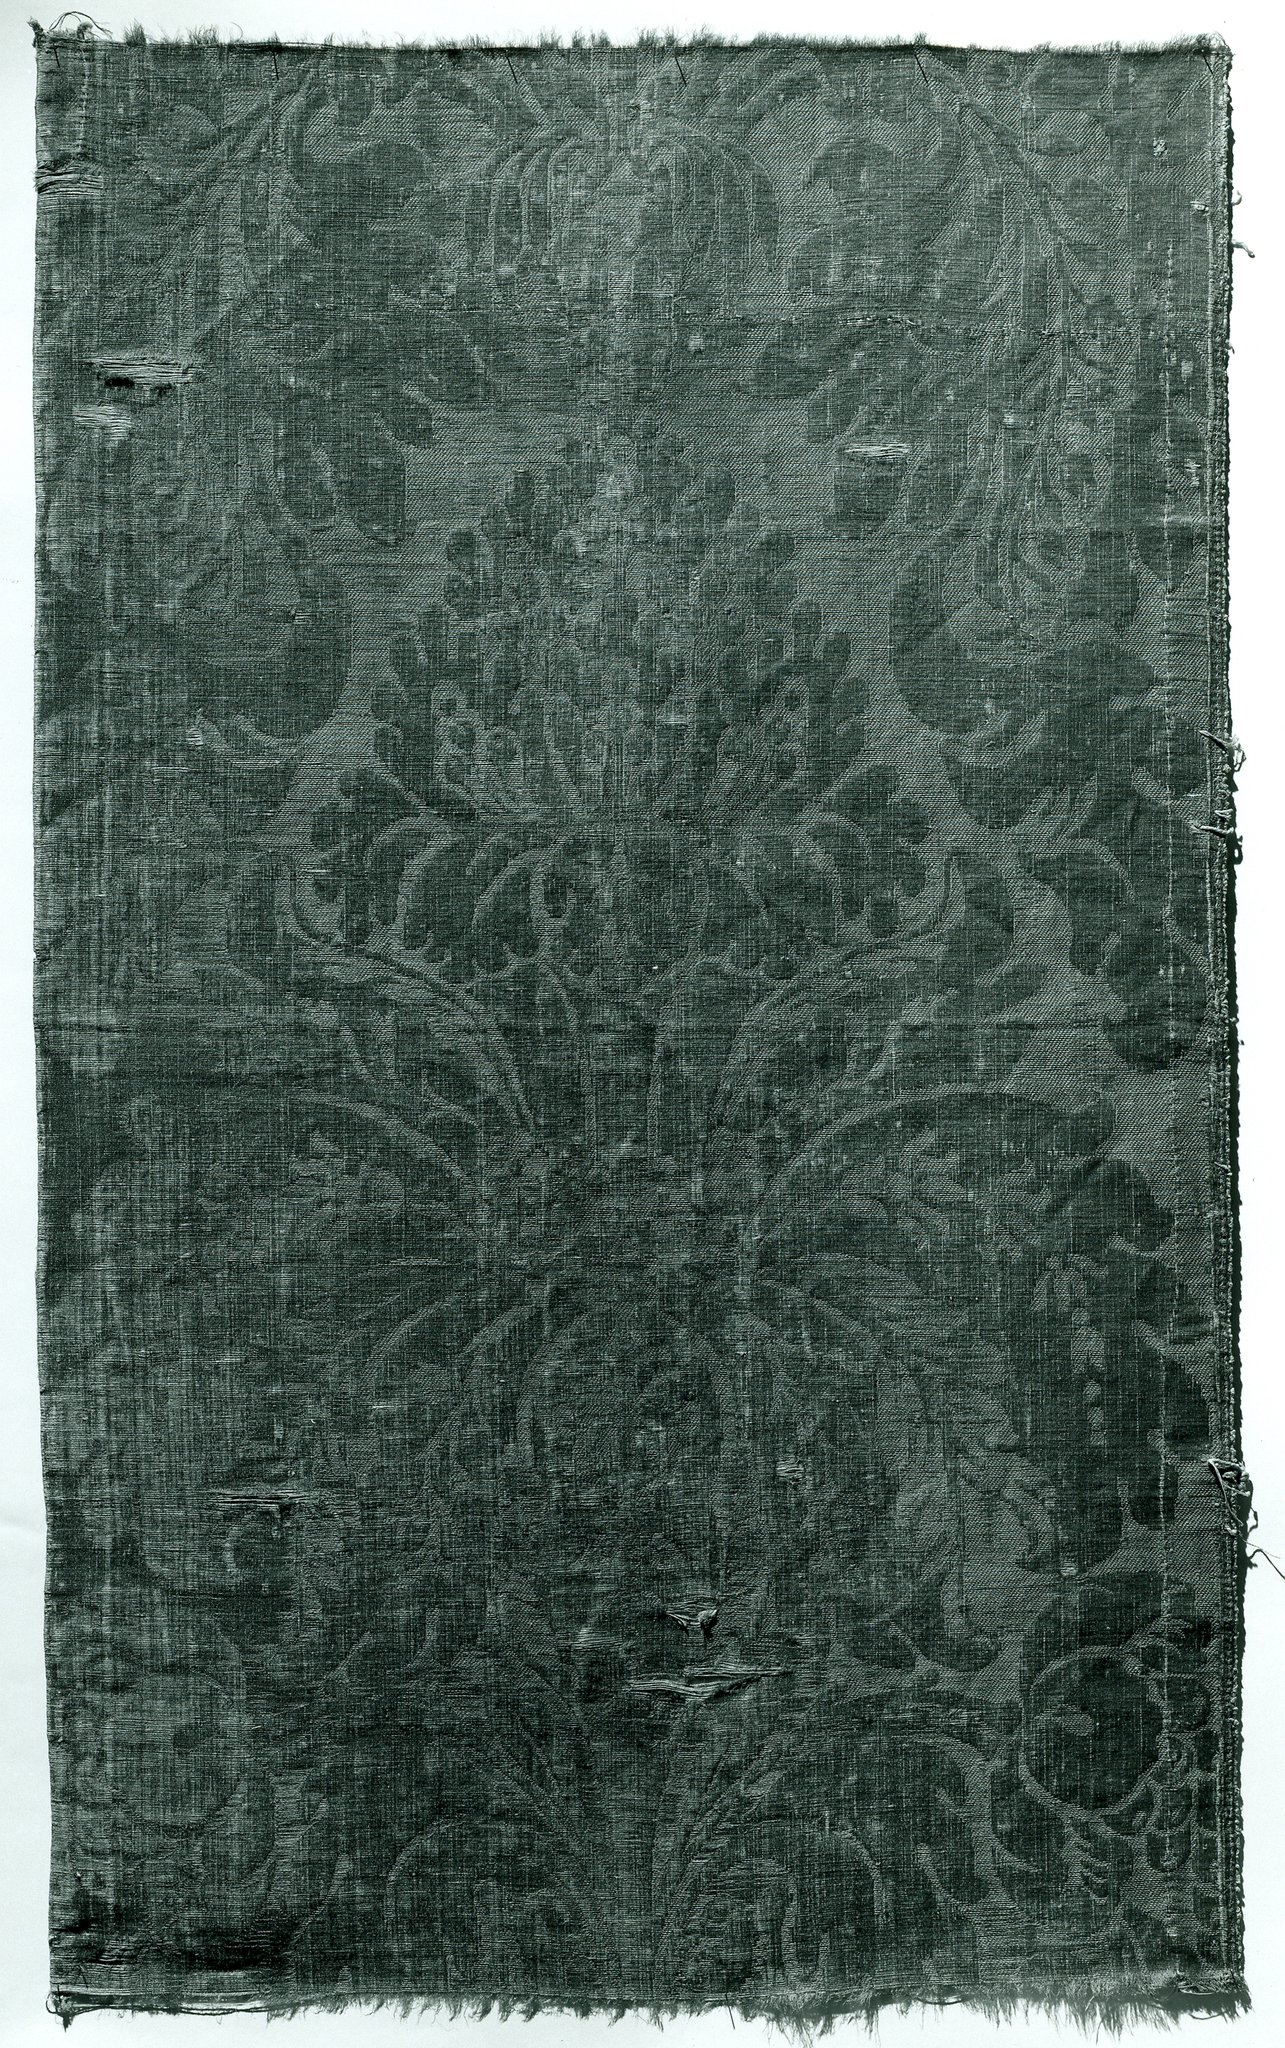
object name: textile panel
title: Panel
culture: italian or spanish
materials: hemp, linen, silk